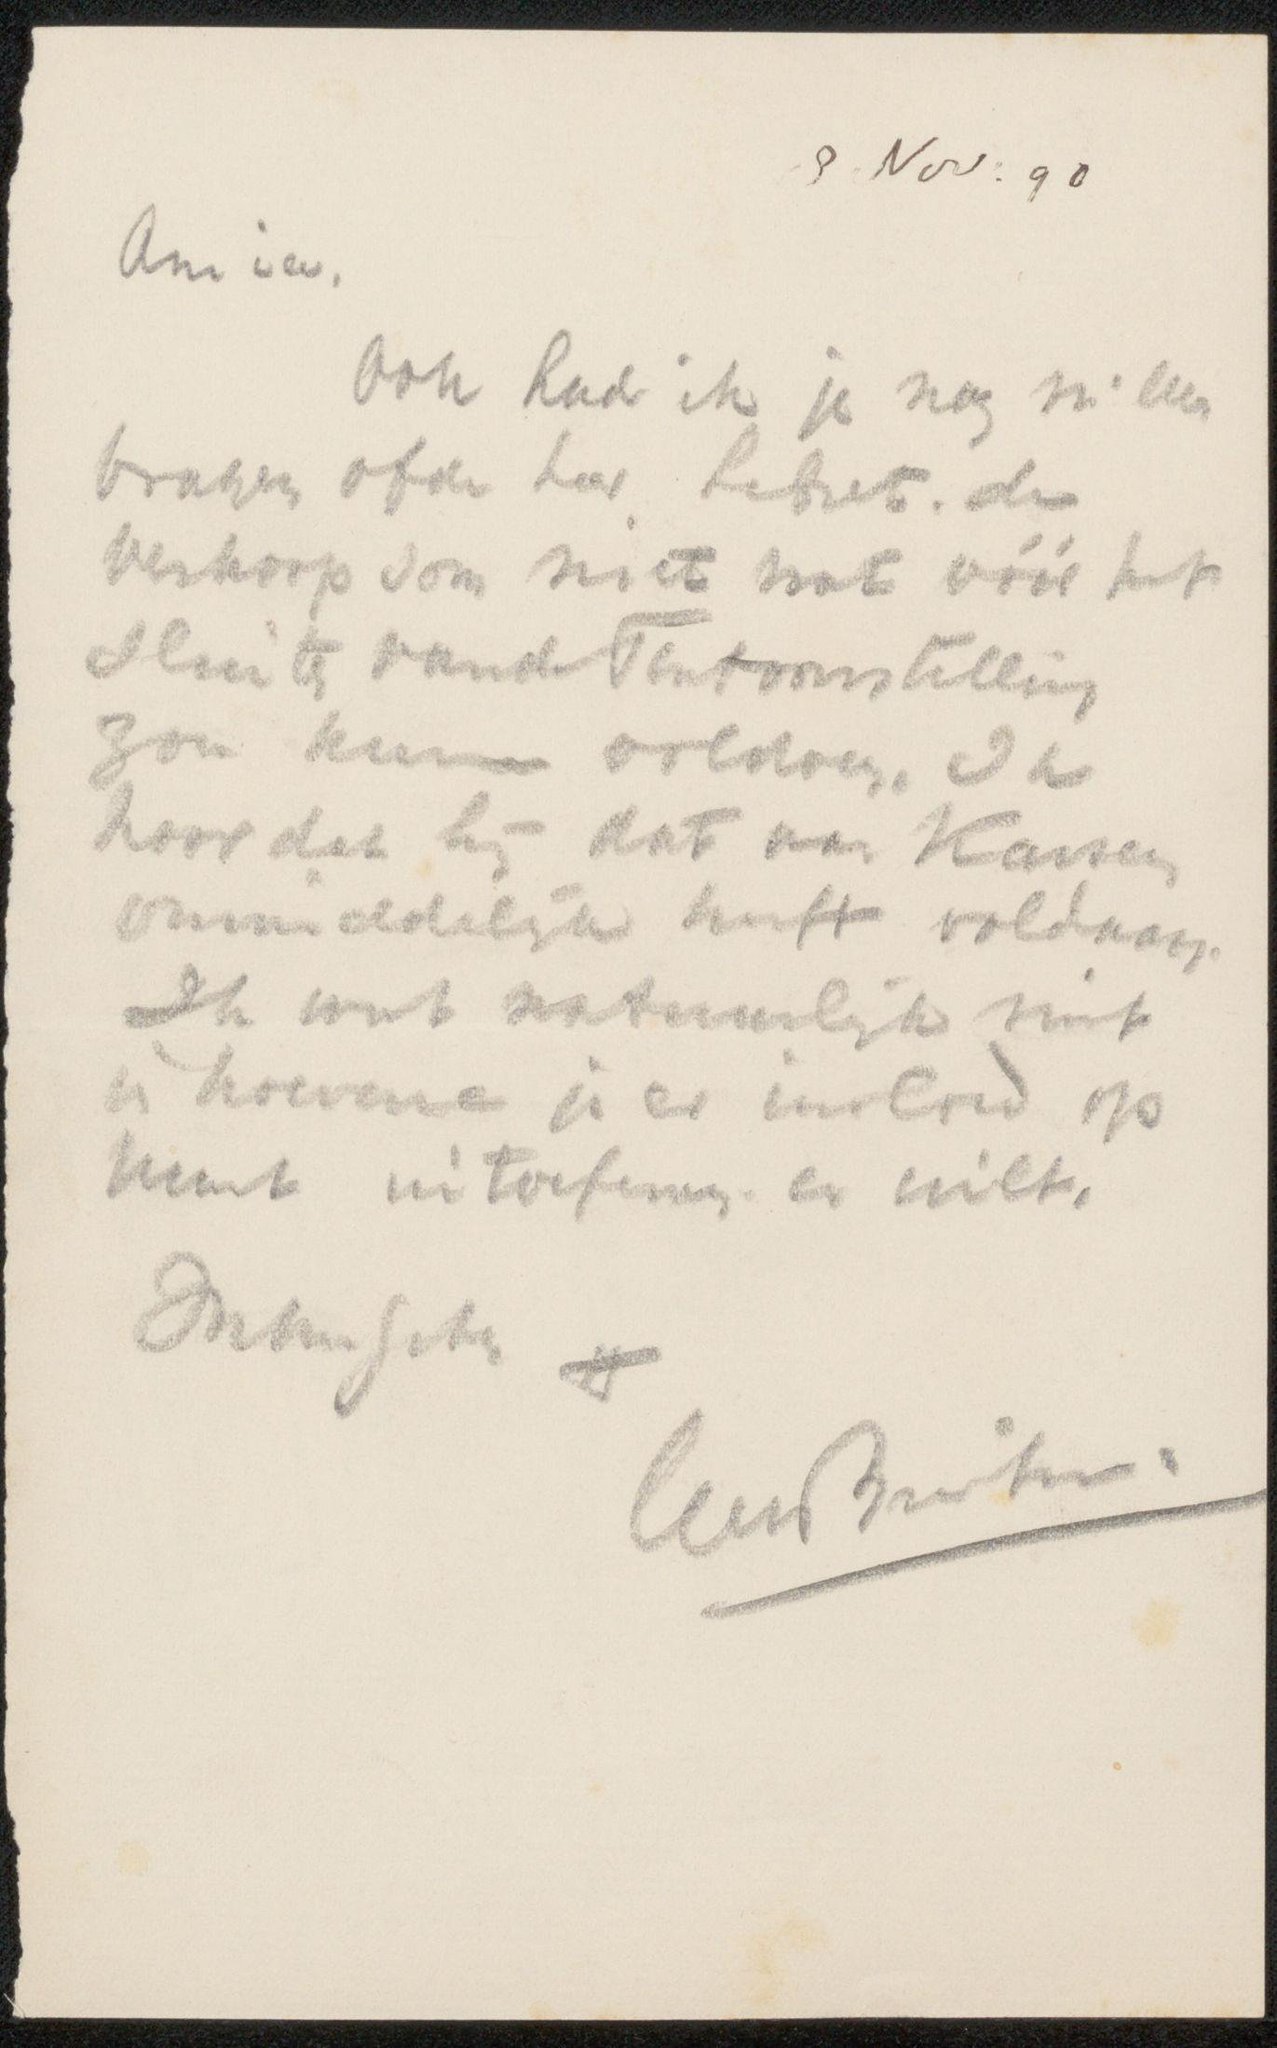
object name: letter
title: Brief aan Jan Veth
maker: george hendrik breitner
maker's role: draughtsman, painter, print maker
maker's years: 1857-1923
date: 1890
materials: ink, paper, pencil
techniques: pen, writing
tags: painter, print maker, draughtsman, jan veth, eduard karsen, dordrecht, martinus cornelis lebret, art trade, art shop, exhibition ~ art, art collecting, money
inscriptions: watermark, collector's mark: ‘RPK’